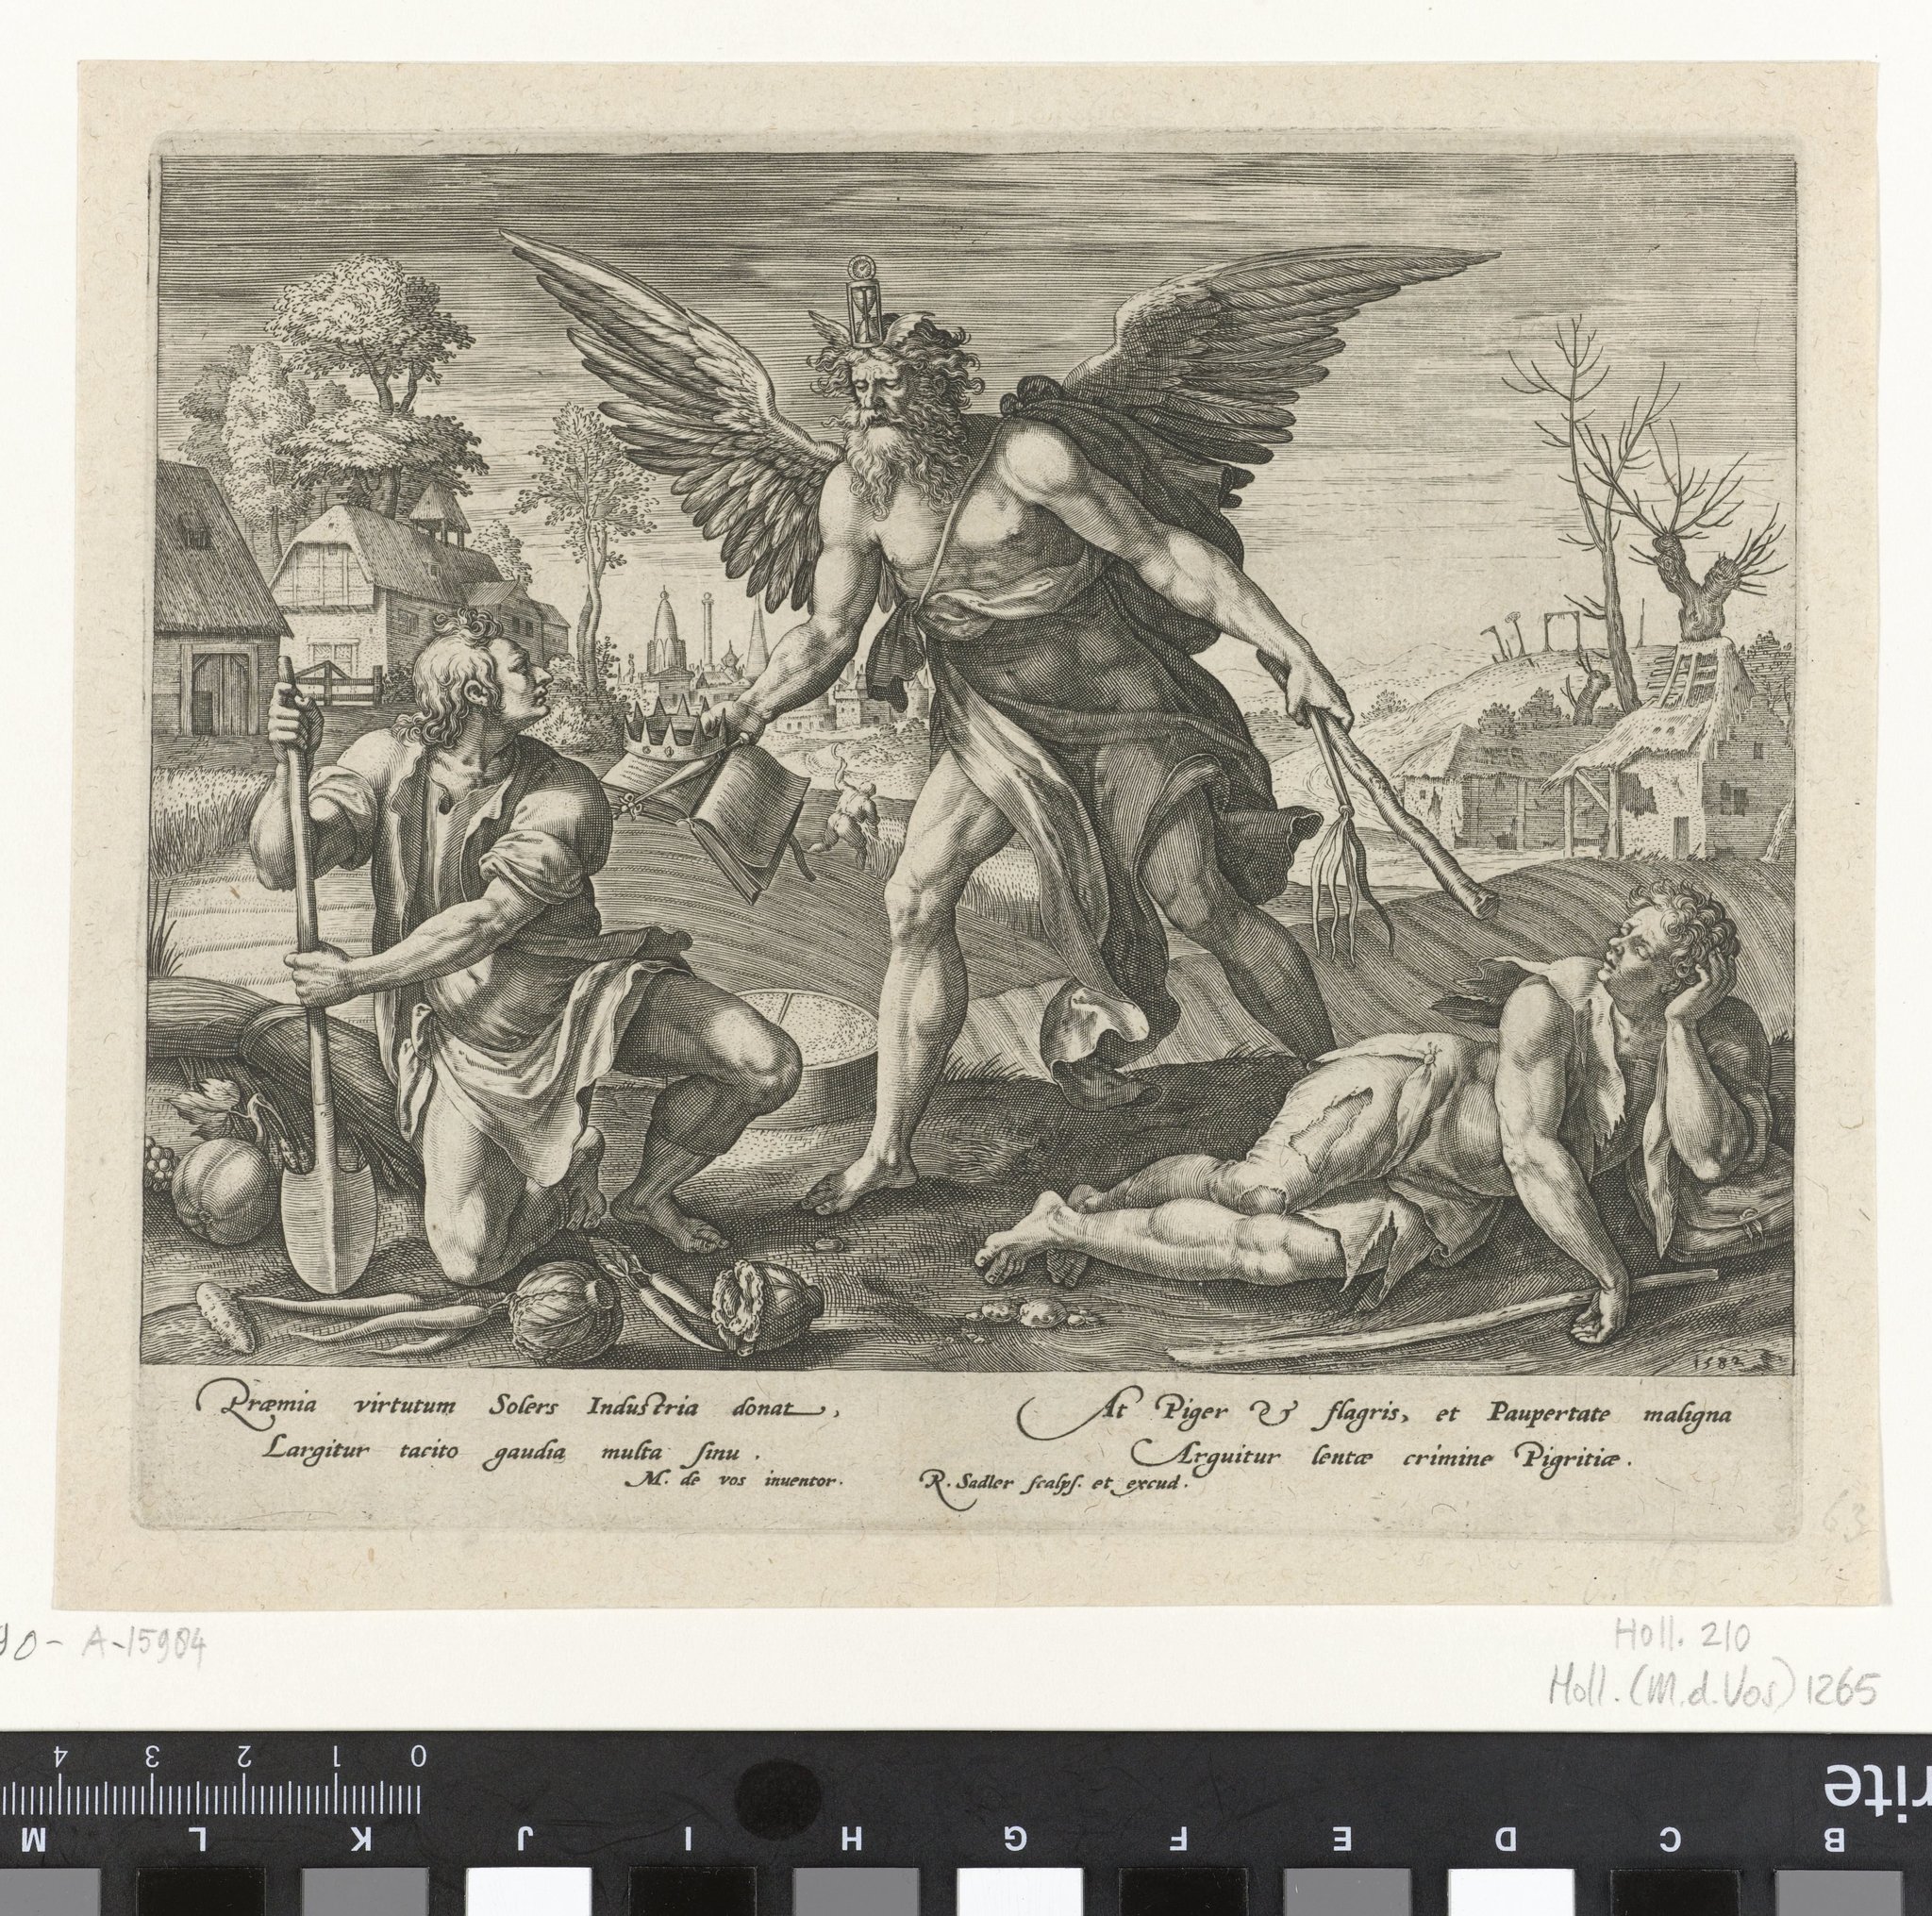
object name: print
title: Tijd beloont arbeid en bestraft de luiheid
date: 1582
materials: paper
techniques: engraving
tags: time rewarding industry and punishing sloth, sloth, indolence, 'acedia', 'desidia'; 'accidia' (ripa) ~ personification of one of the seven deadly sins, father time, man with wings and scythe, labour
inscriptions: collector's mark: Lugt 2228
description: Vader Tijd als oude man met zandloper op het hoofd. Hij geeft een scepter, een kroon en een boek aan de personificatie van Arbeid, een man met een spade in de hand. Rondom Arbeid liggen verschillende groenten. Vader Tijd geeft een stok en een geselroede aan de personificatie van Luiheid, een man op de rechtervoorgrond die ligt te slapen. Op de achtergrond links een welvarende landstreek en rechts armoedige hutten, dode bomen en een galgenveld. De prent heeft een Latijns onderschrift.